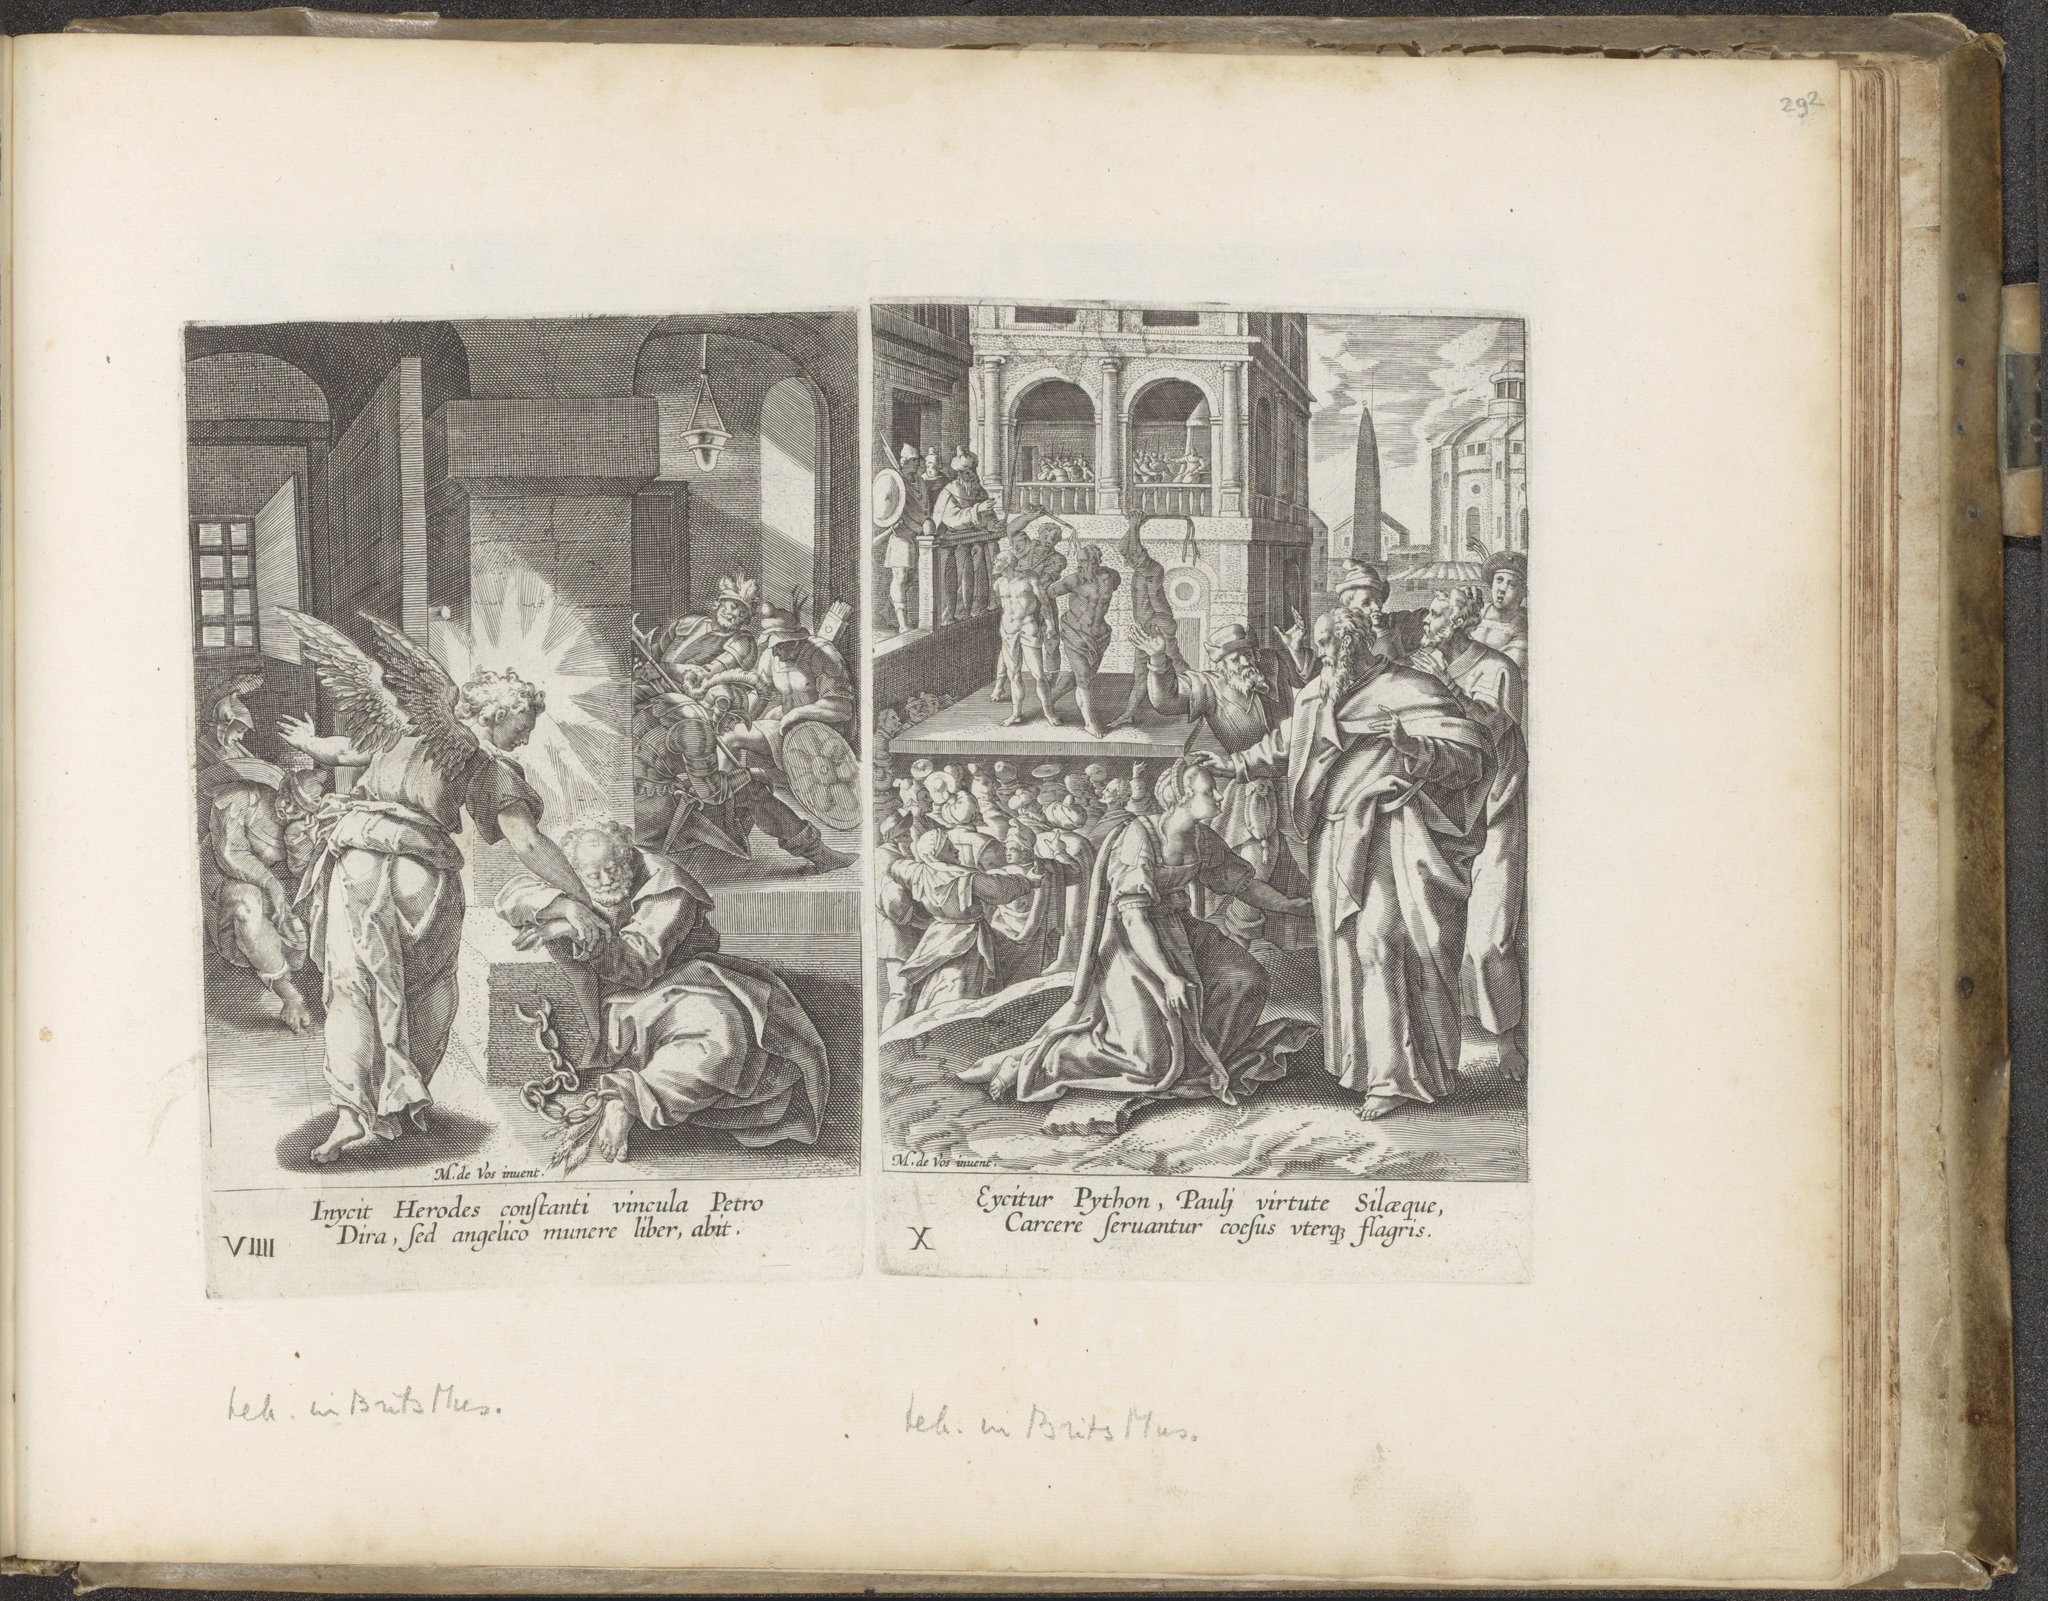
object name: album leaf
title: Handelingen van de apostelen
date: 1591-1600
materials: paper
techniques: engraving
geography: amsterdam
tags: paul and silas are whipped, an angel appears, summoning peter to wake up ~ peter in prison, the healing of the woman servant with a divining spirit ~ paul and silas at philippi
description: Twee voorstellingen op een albumblad. Links de bevrijding van Petrus. Petrus slaapt in de gevangenis en wordt door vier soldaten, die ook in slaap zijn gevallen, bewaakt. Naast Petrus verschijnt een engel, die hem wakker probeert te maken, zodat hij bevrijd kan worden. Op de rechter voorstelling Paulus en Silas in Filippi. Paulus geneest een jonge tot slaaf gemaakte vrouw die de toekomst kan voorspellen. Op de achtergrond worden Paulus en Silas gegeseld in opdracht van de stadsbestuurders, die door de eigenaars van de vrouw getipt waren. Onder beide voorstellingen een tweeregelig onderschrift in het Latijn. Het blad maakt deel uit van een album.